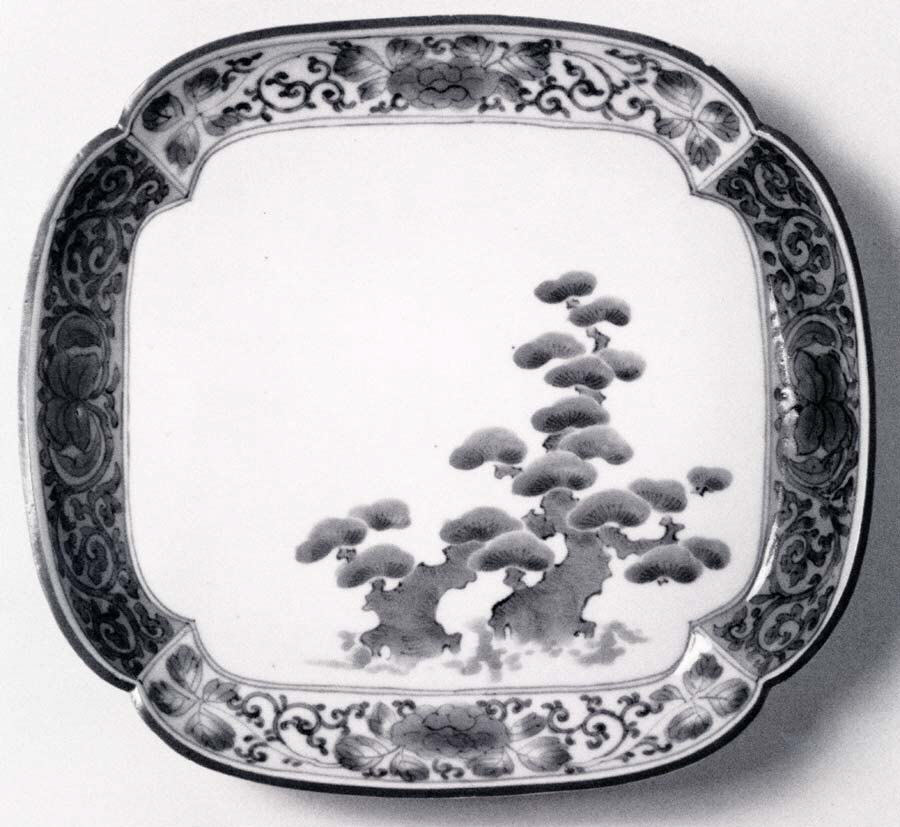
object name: dish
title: Square-Lobed Dish with Decoration of Old Pine Trees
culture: japanese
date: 1701-1733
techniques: glazing, underglaze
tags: trees